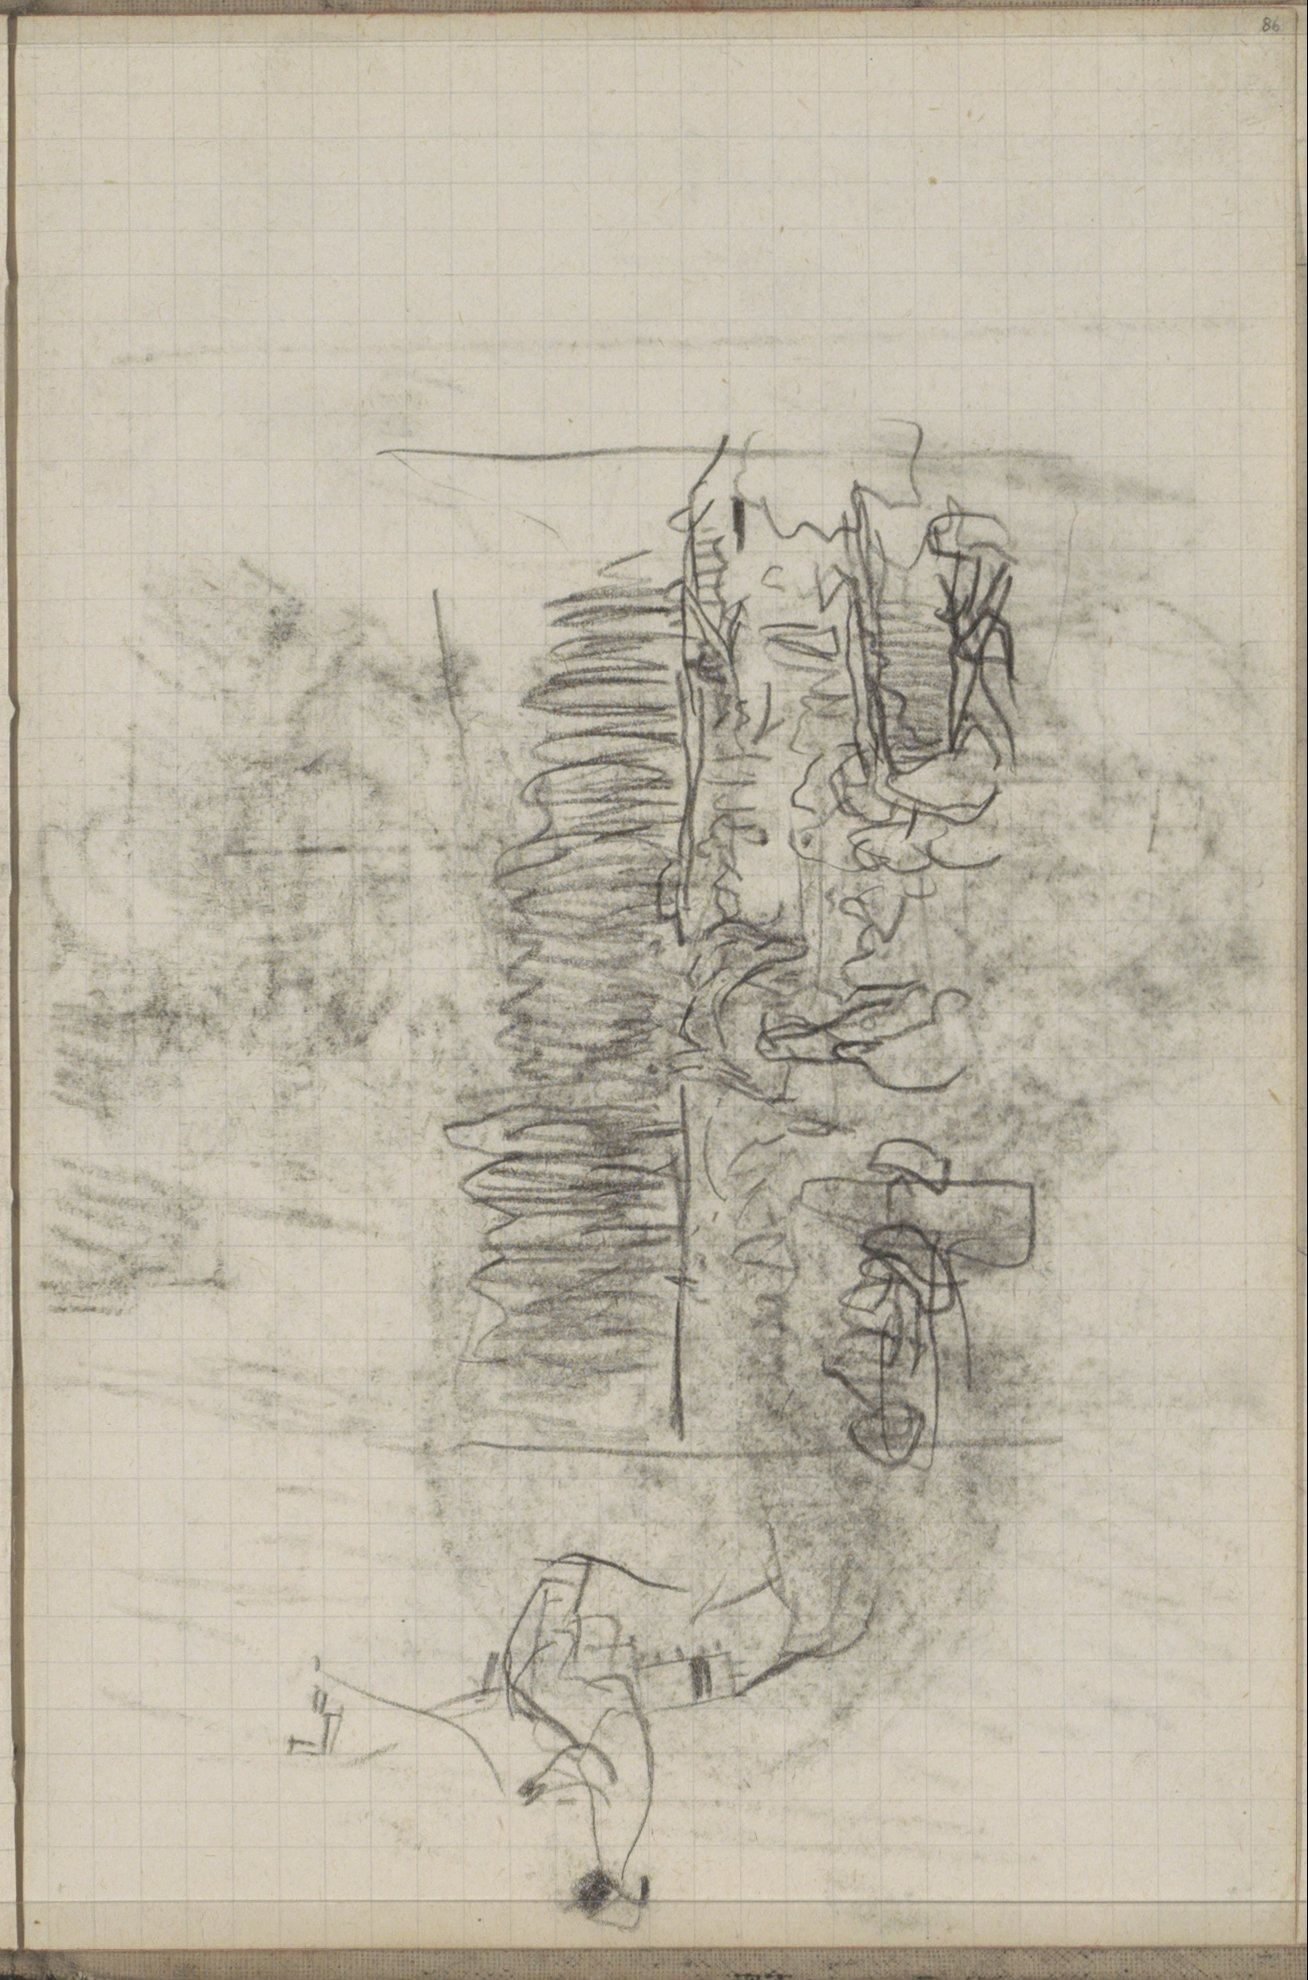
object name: sketchbook leaf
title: Ruiter en landschap met bomen en figuren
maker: marius bauer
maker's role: draughtsman, print maker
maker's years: 1867-1932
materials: chalk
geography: istanbul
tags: riding a horse, ass, or mule; rider, horseman, landscapes (+ landscape with figures, staffage)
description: Pagina 86 uit een schetsboek met 54 bladen.